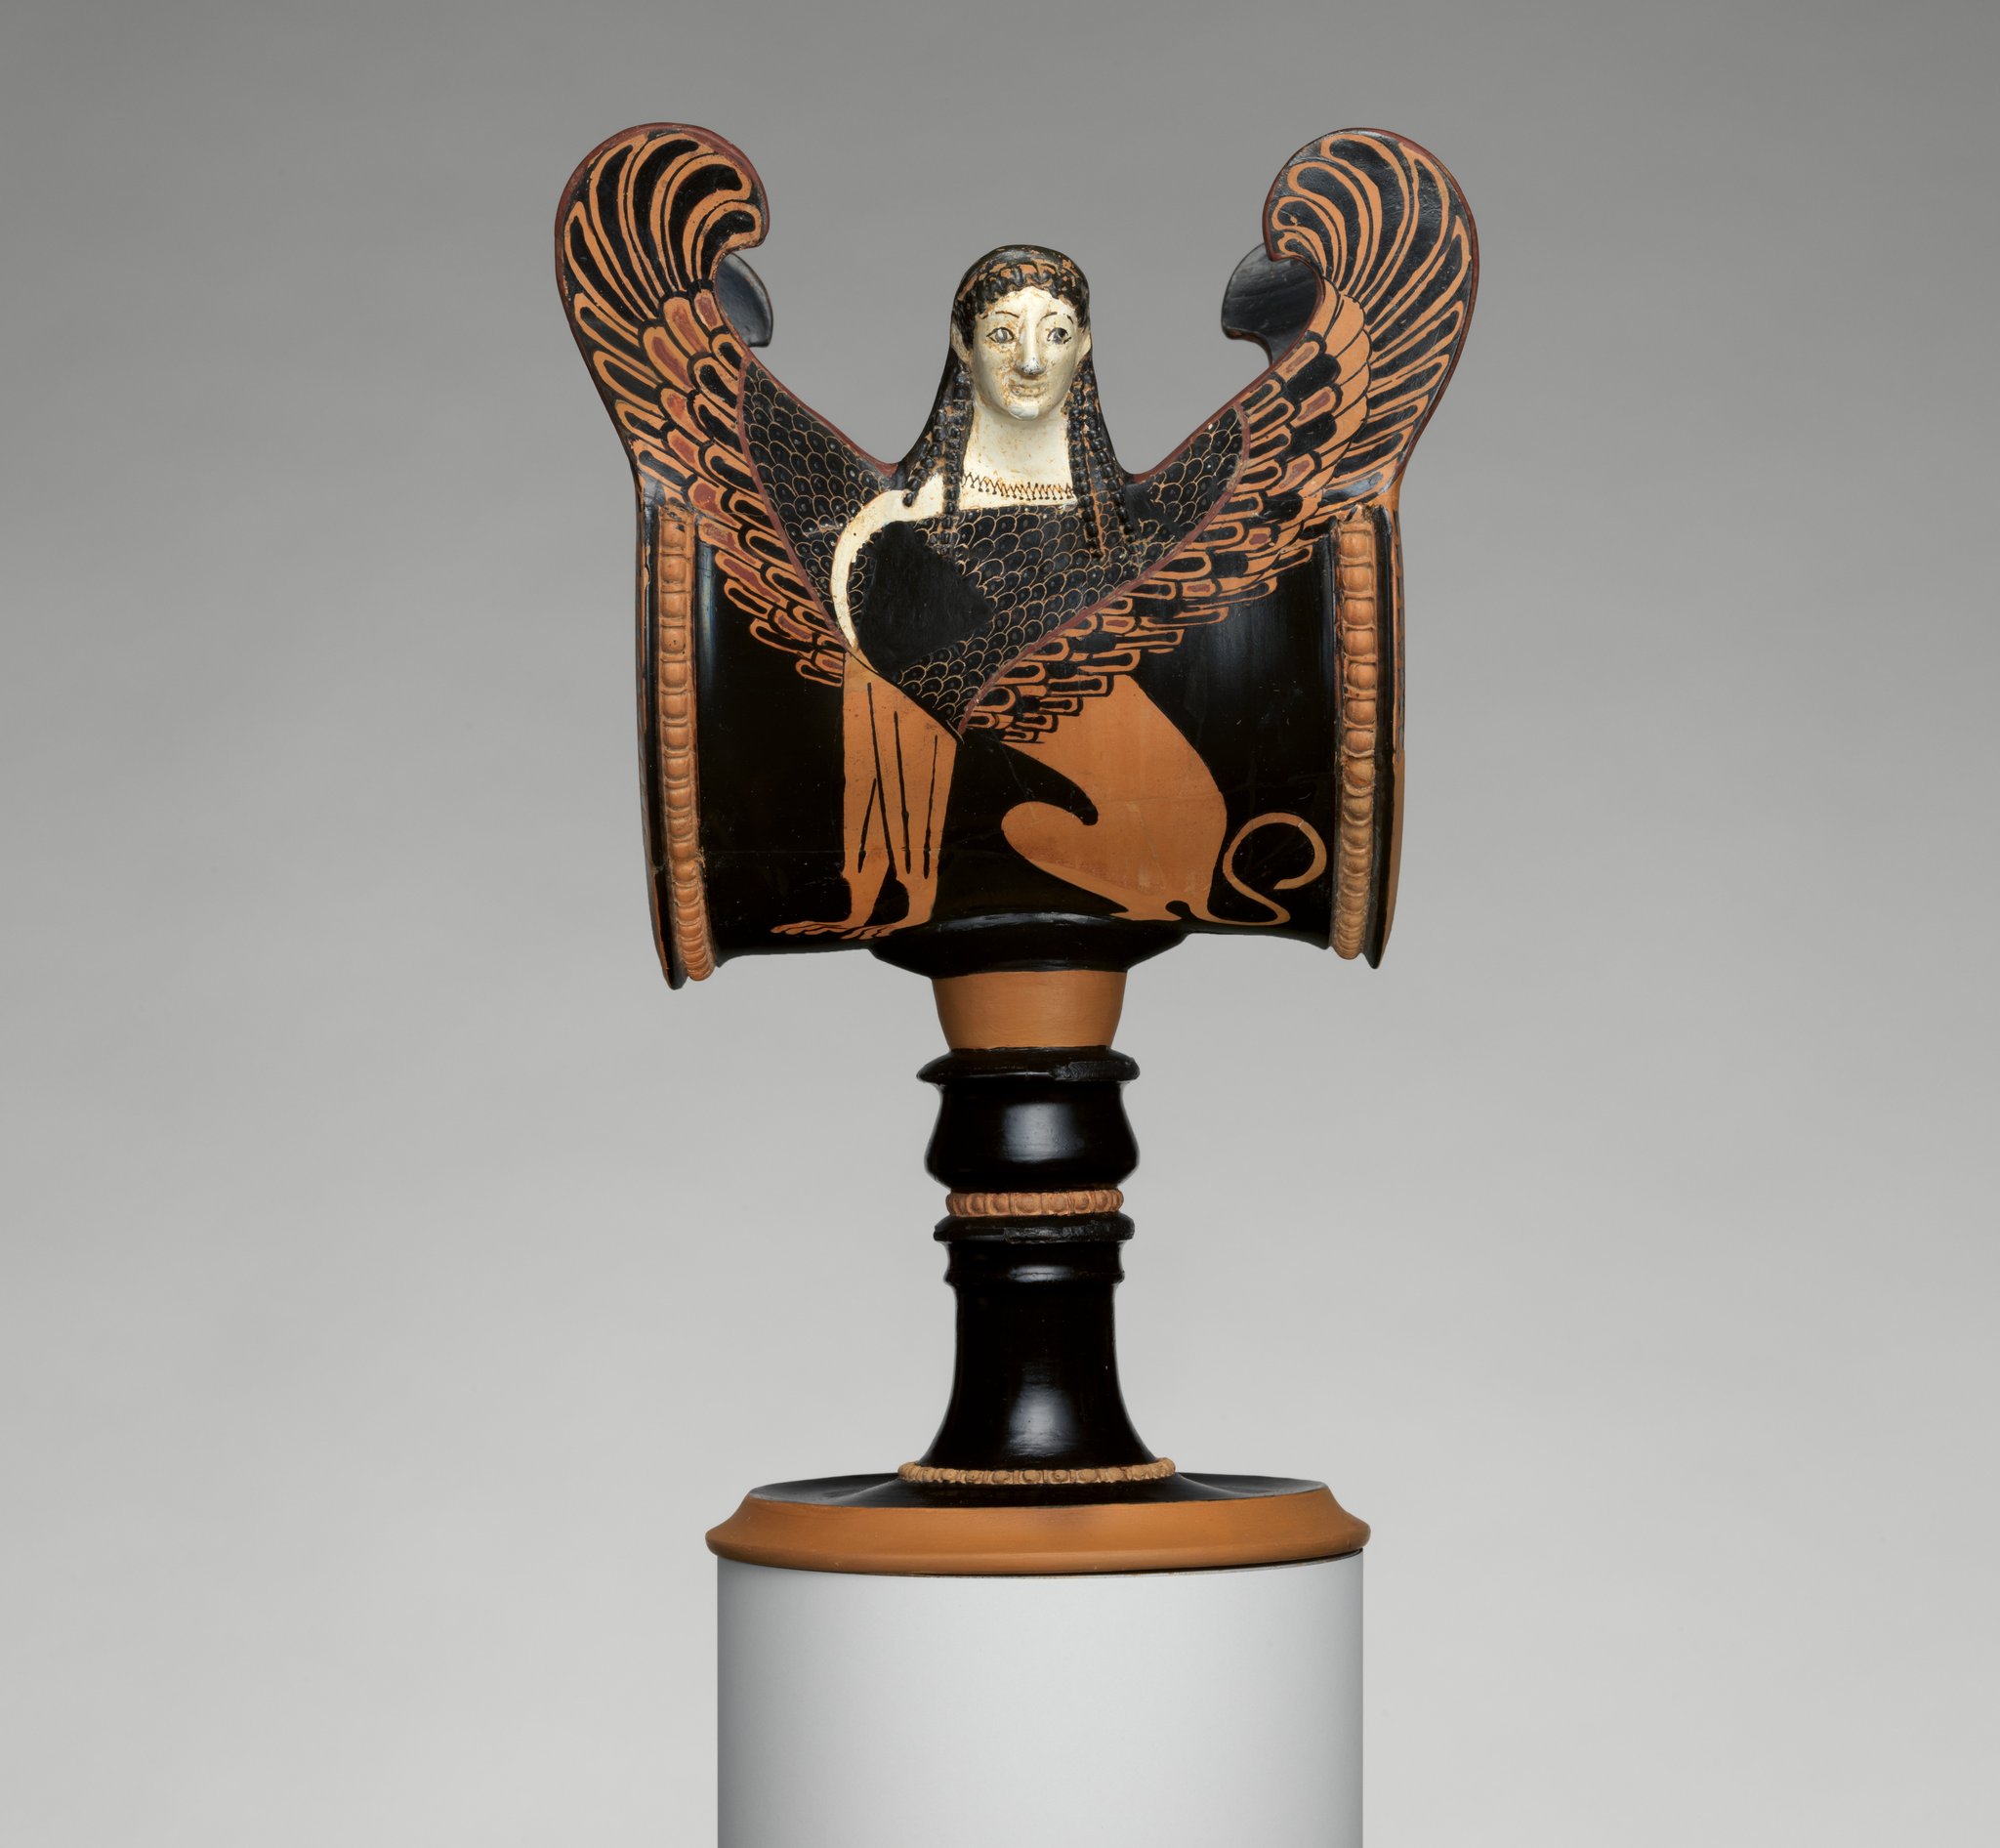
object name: stand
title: Terracotta stand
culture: greek, attic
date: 520 BCE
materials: terracotta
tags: sphinx